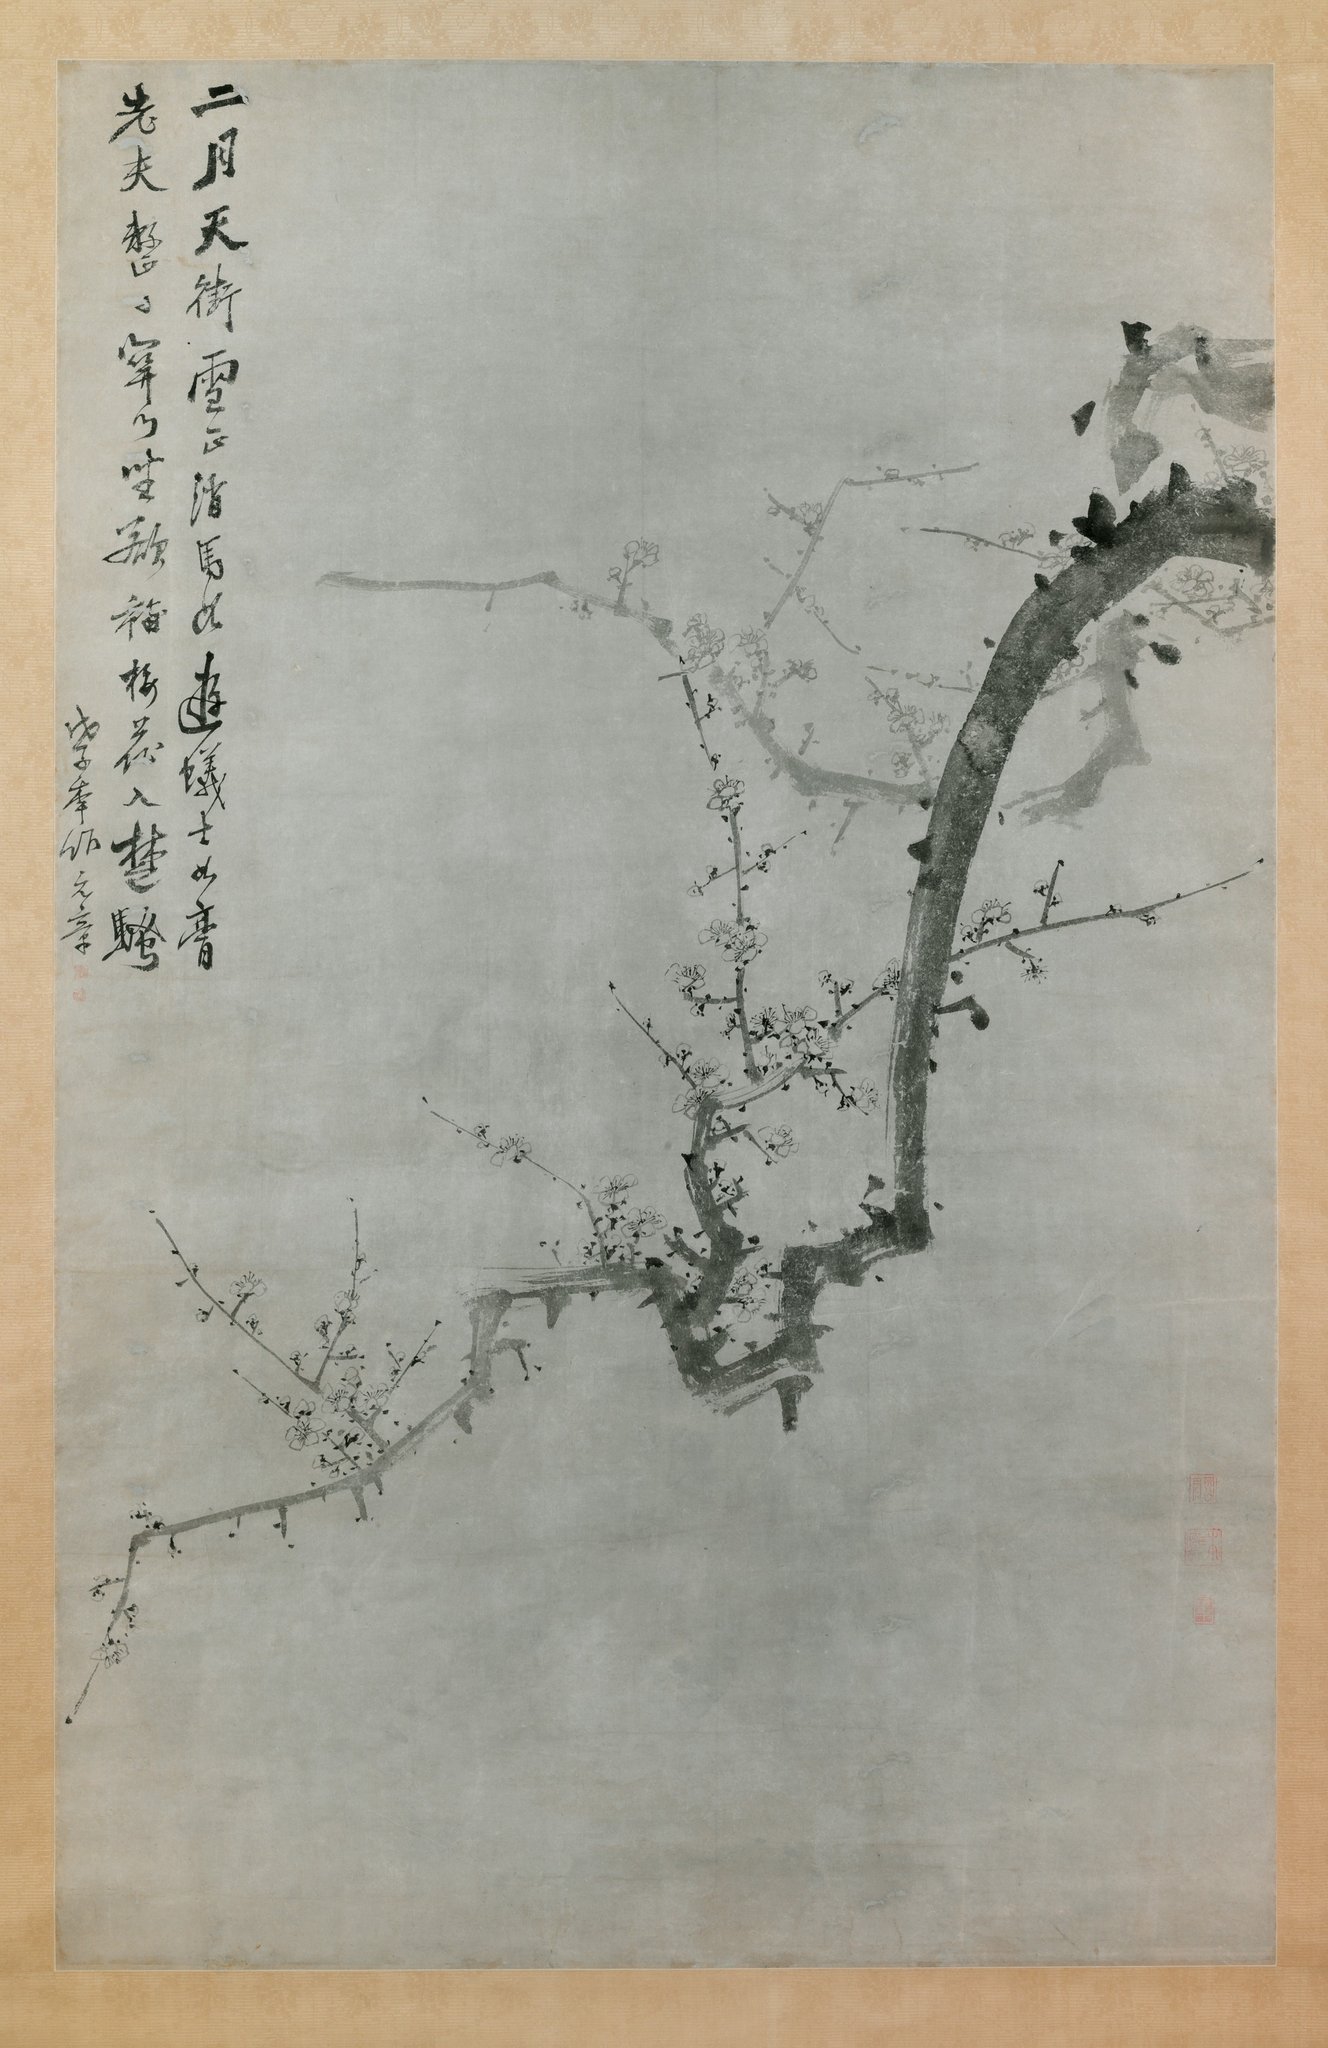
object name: hanging scroll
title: Plum Branch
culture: korean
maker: yi yu-won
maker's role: artist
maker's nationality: korean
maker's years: 1814-1888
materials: ink, paper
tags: trees